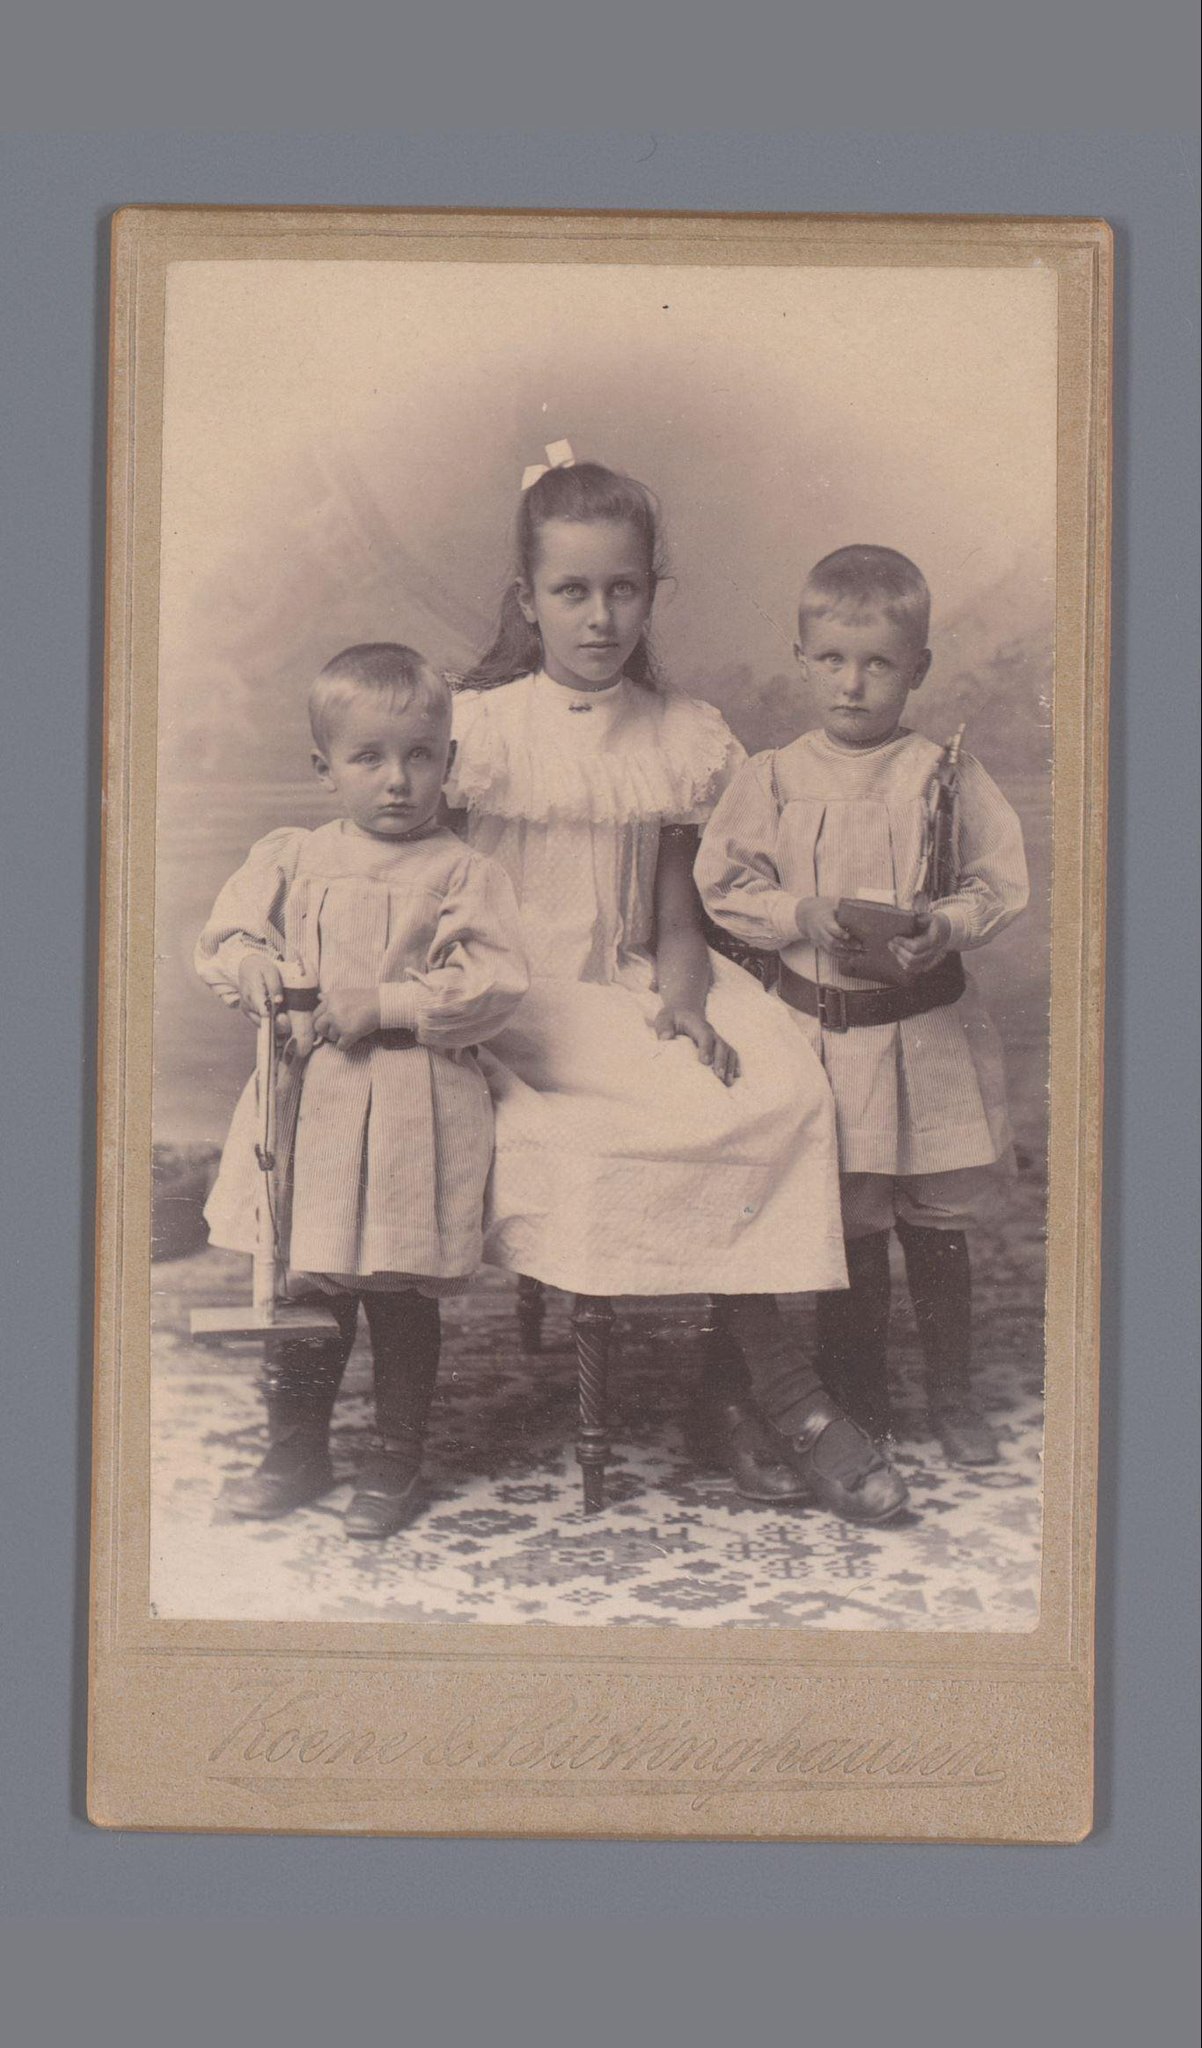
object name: carte de visite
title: Portret van Johanna Geertruida, Lucas en Willem Jonker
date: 1898-1905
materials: cardboard, photographic support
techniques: gelatin silver print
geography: amsterdam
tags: historical persons, amsterdam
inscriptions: workshop stamp: ‘Koene&Büttinghausen/ Amsterdam Heerengracht 150, Telephoonnummer 1402/ Batavia’